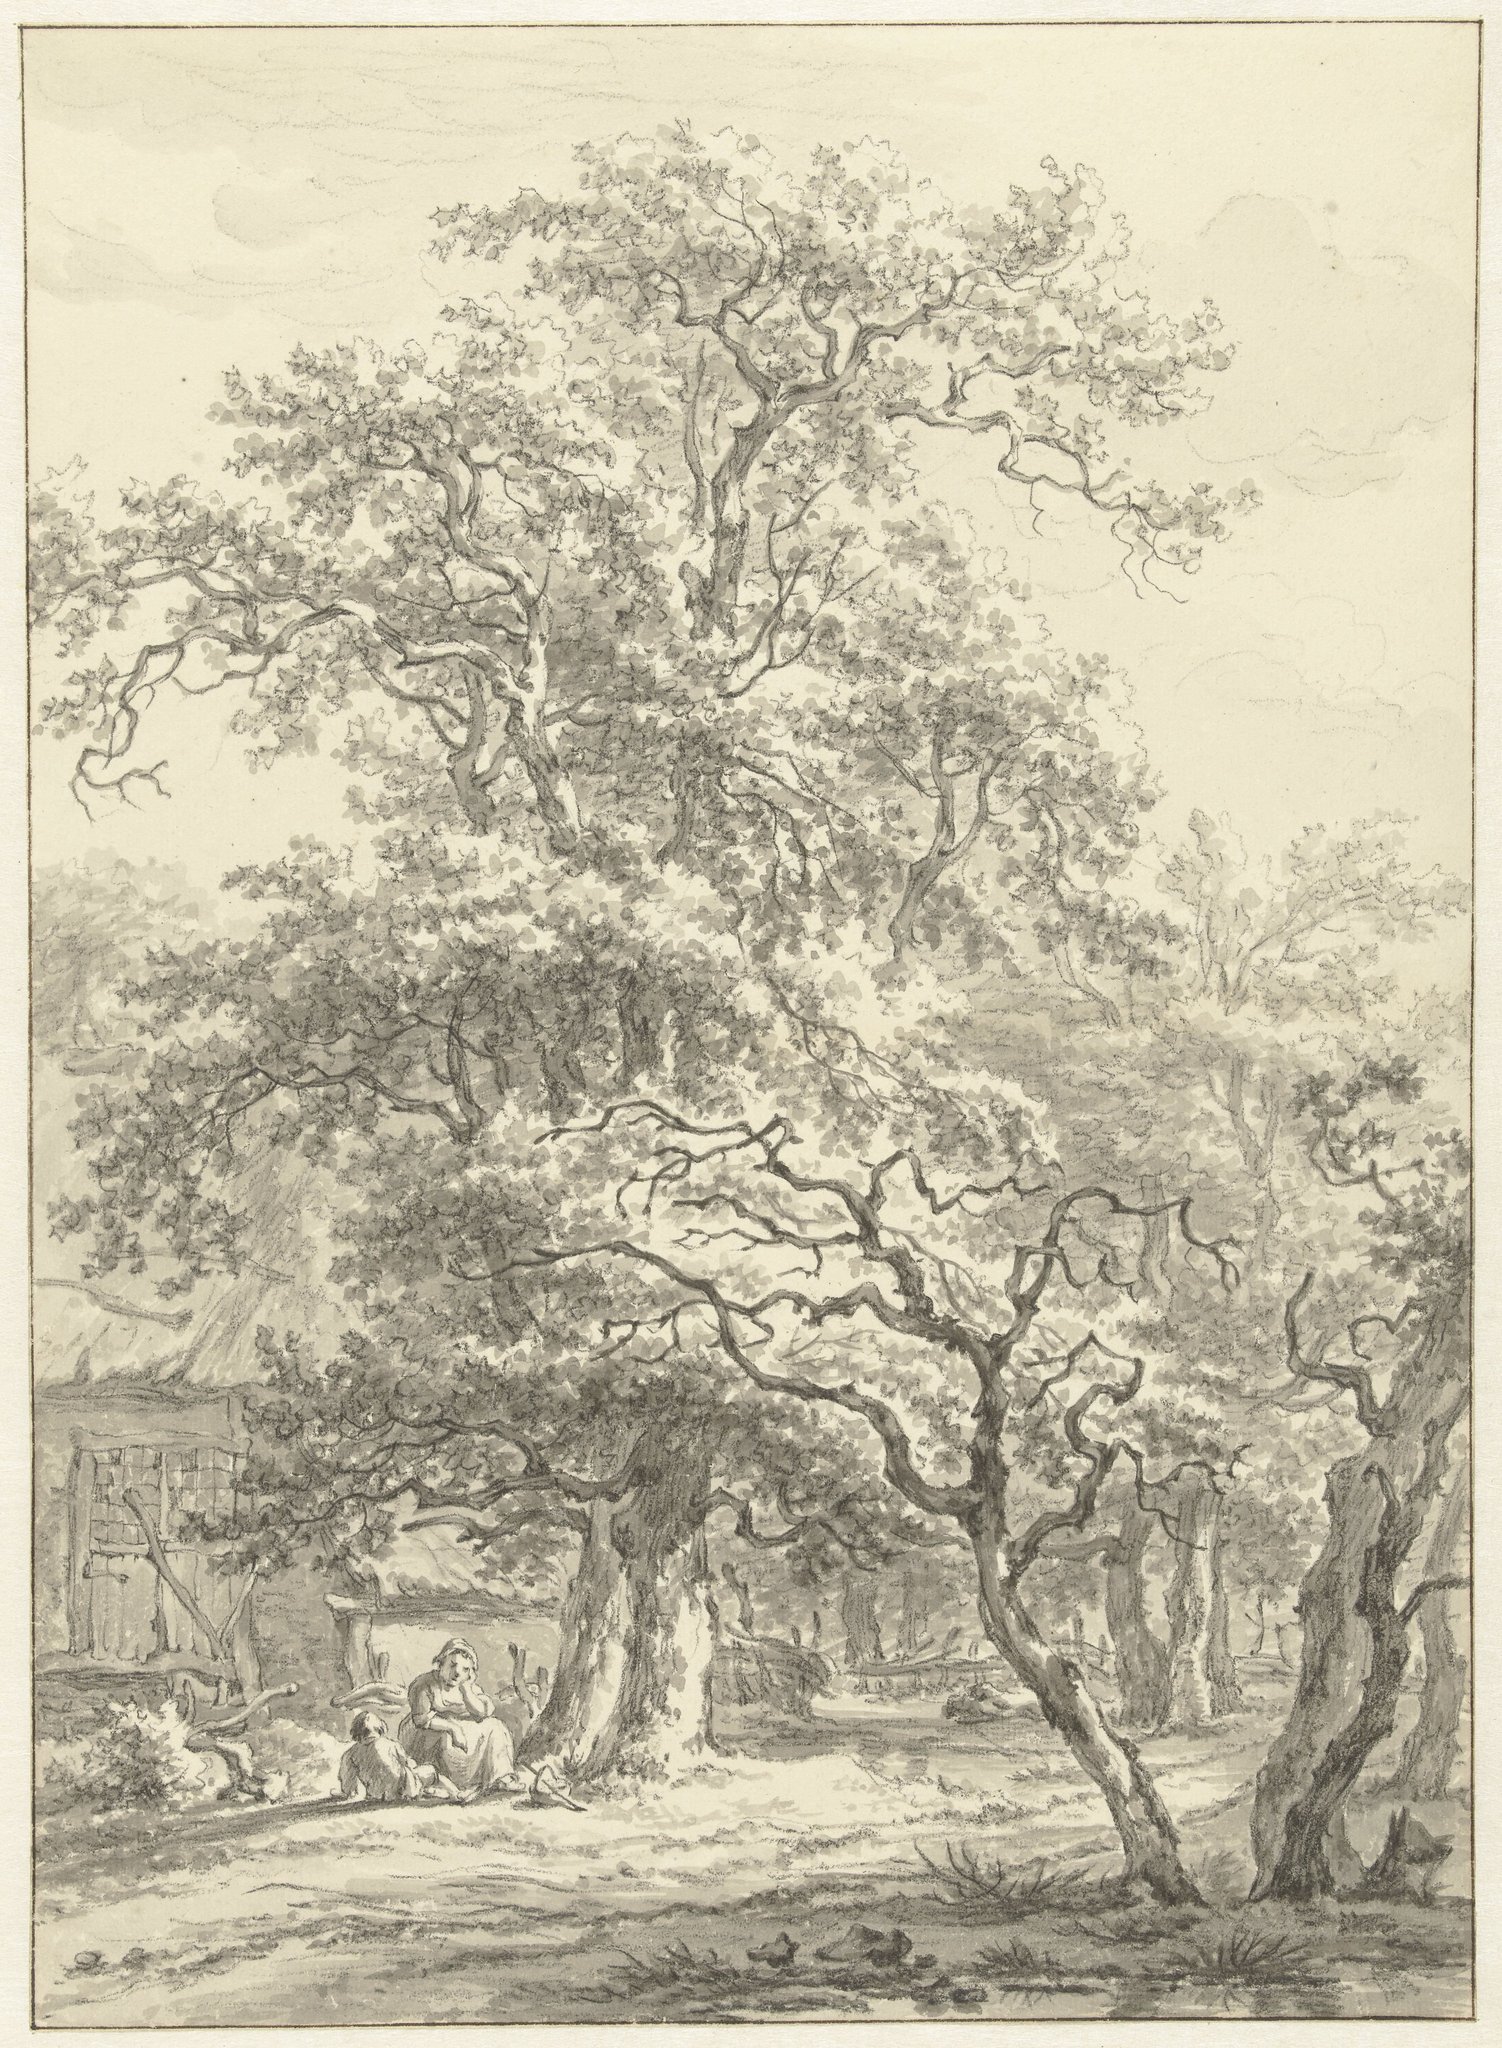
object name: drawing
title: Moeder en kind zittend onder bomen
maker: egbert van drielst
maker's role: draughtsman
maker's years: 1745-1818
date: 1755-1818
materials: chalk, paper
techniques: brush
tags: mother and baby or young child